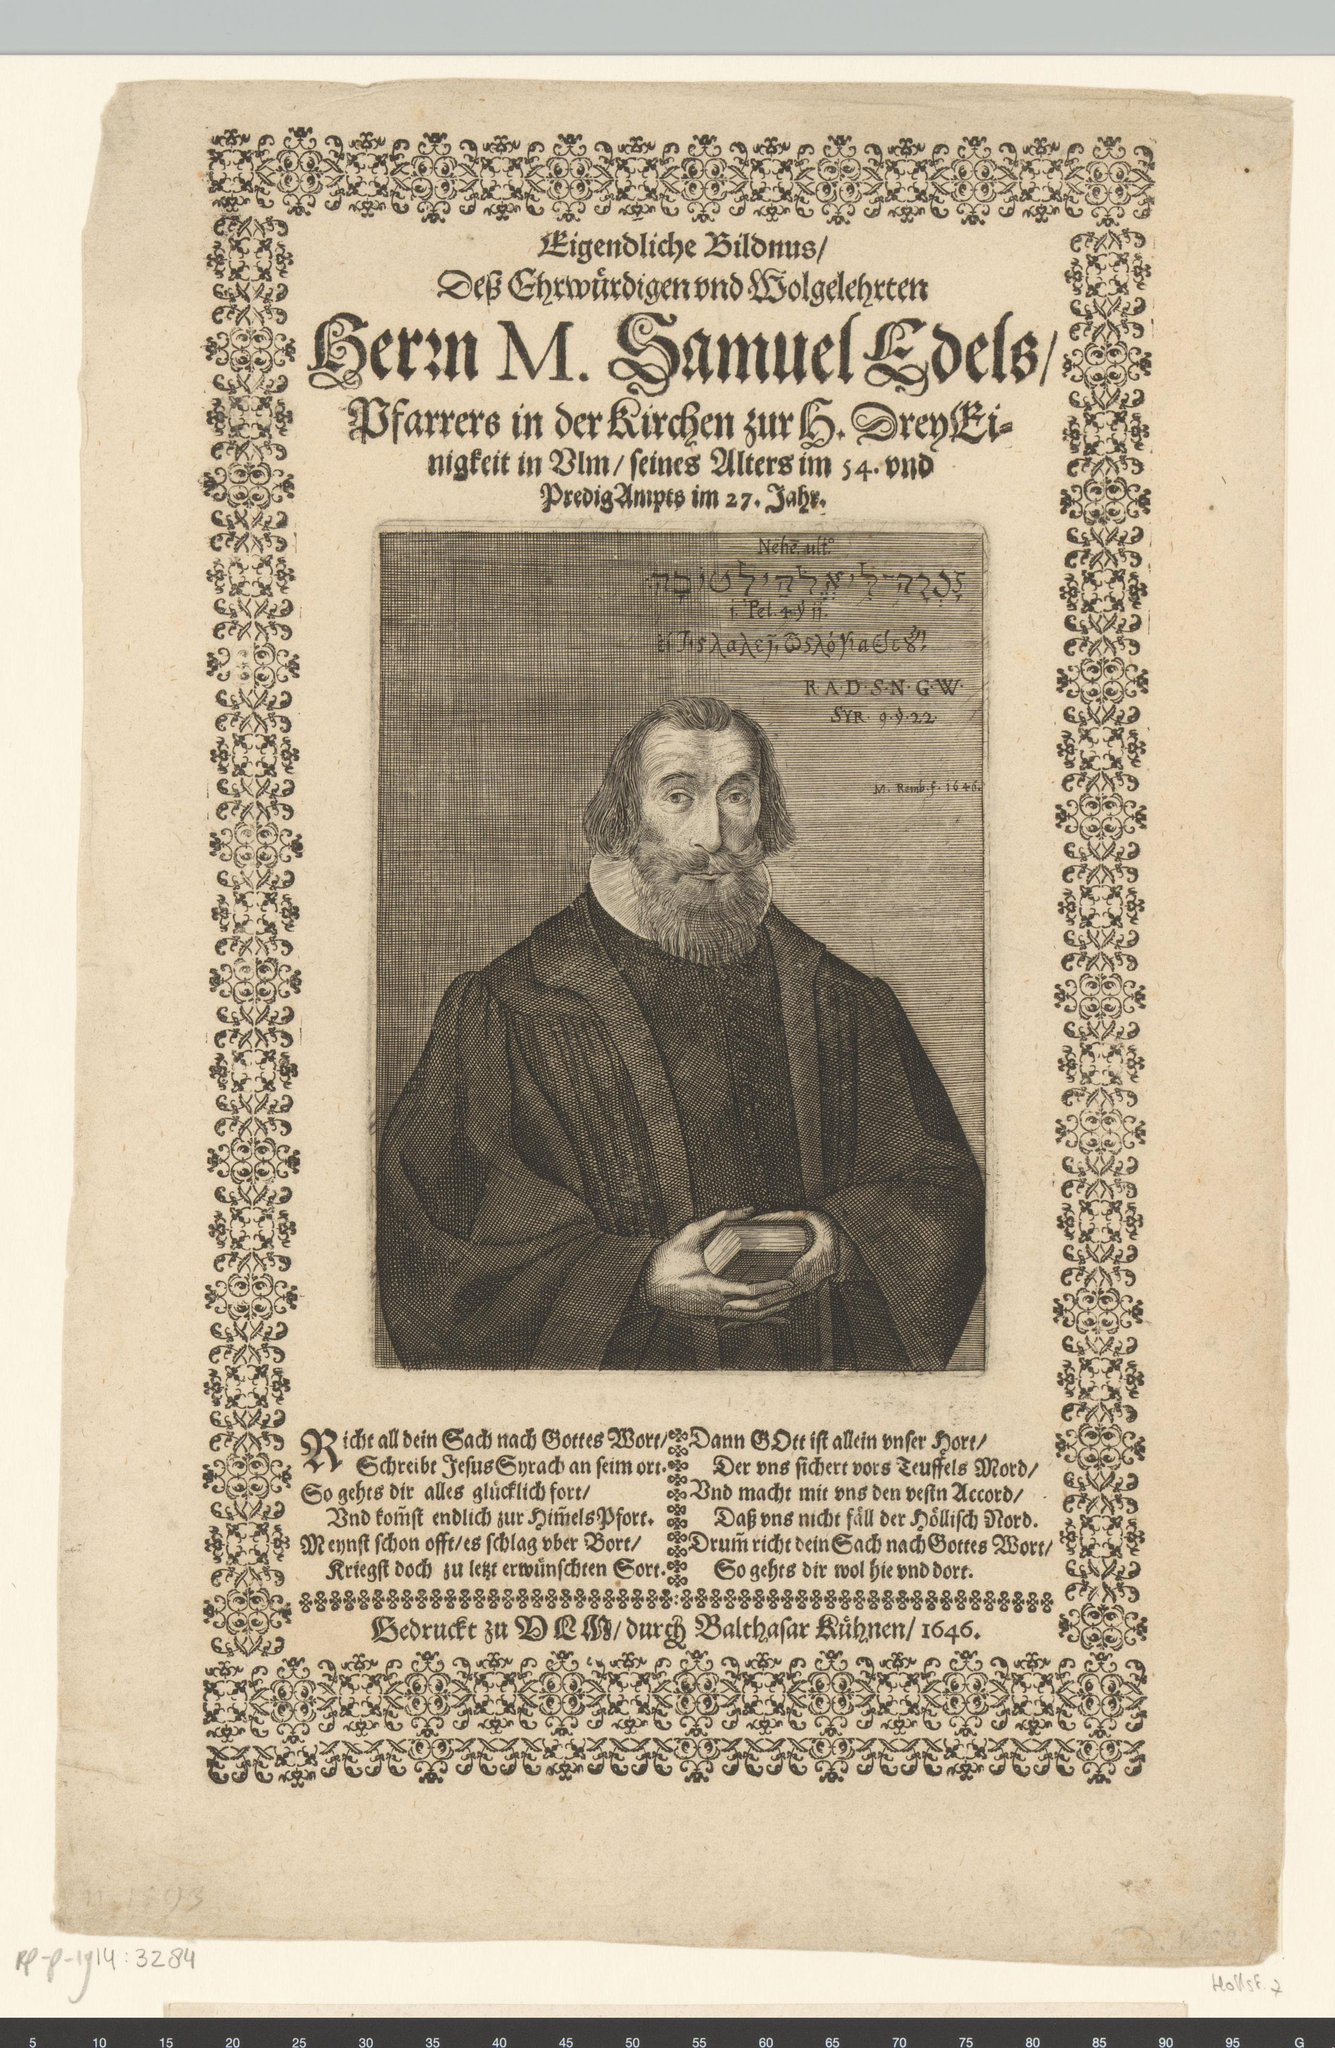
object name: print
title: Portret van Samuel Edel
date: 1646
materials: paper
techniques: engraving, letterpress printing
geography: ulm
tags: historical persons, book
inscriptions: collector's mark: Lugt 2228